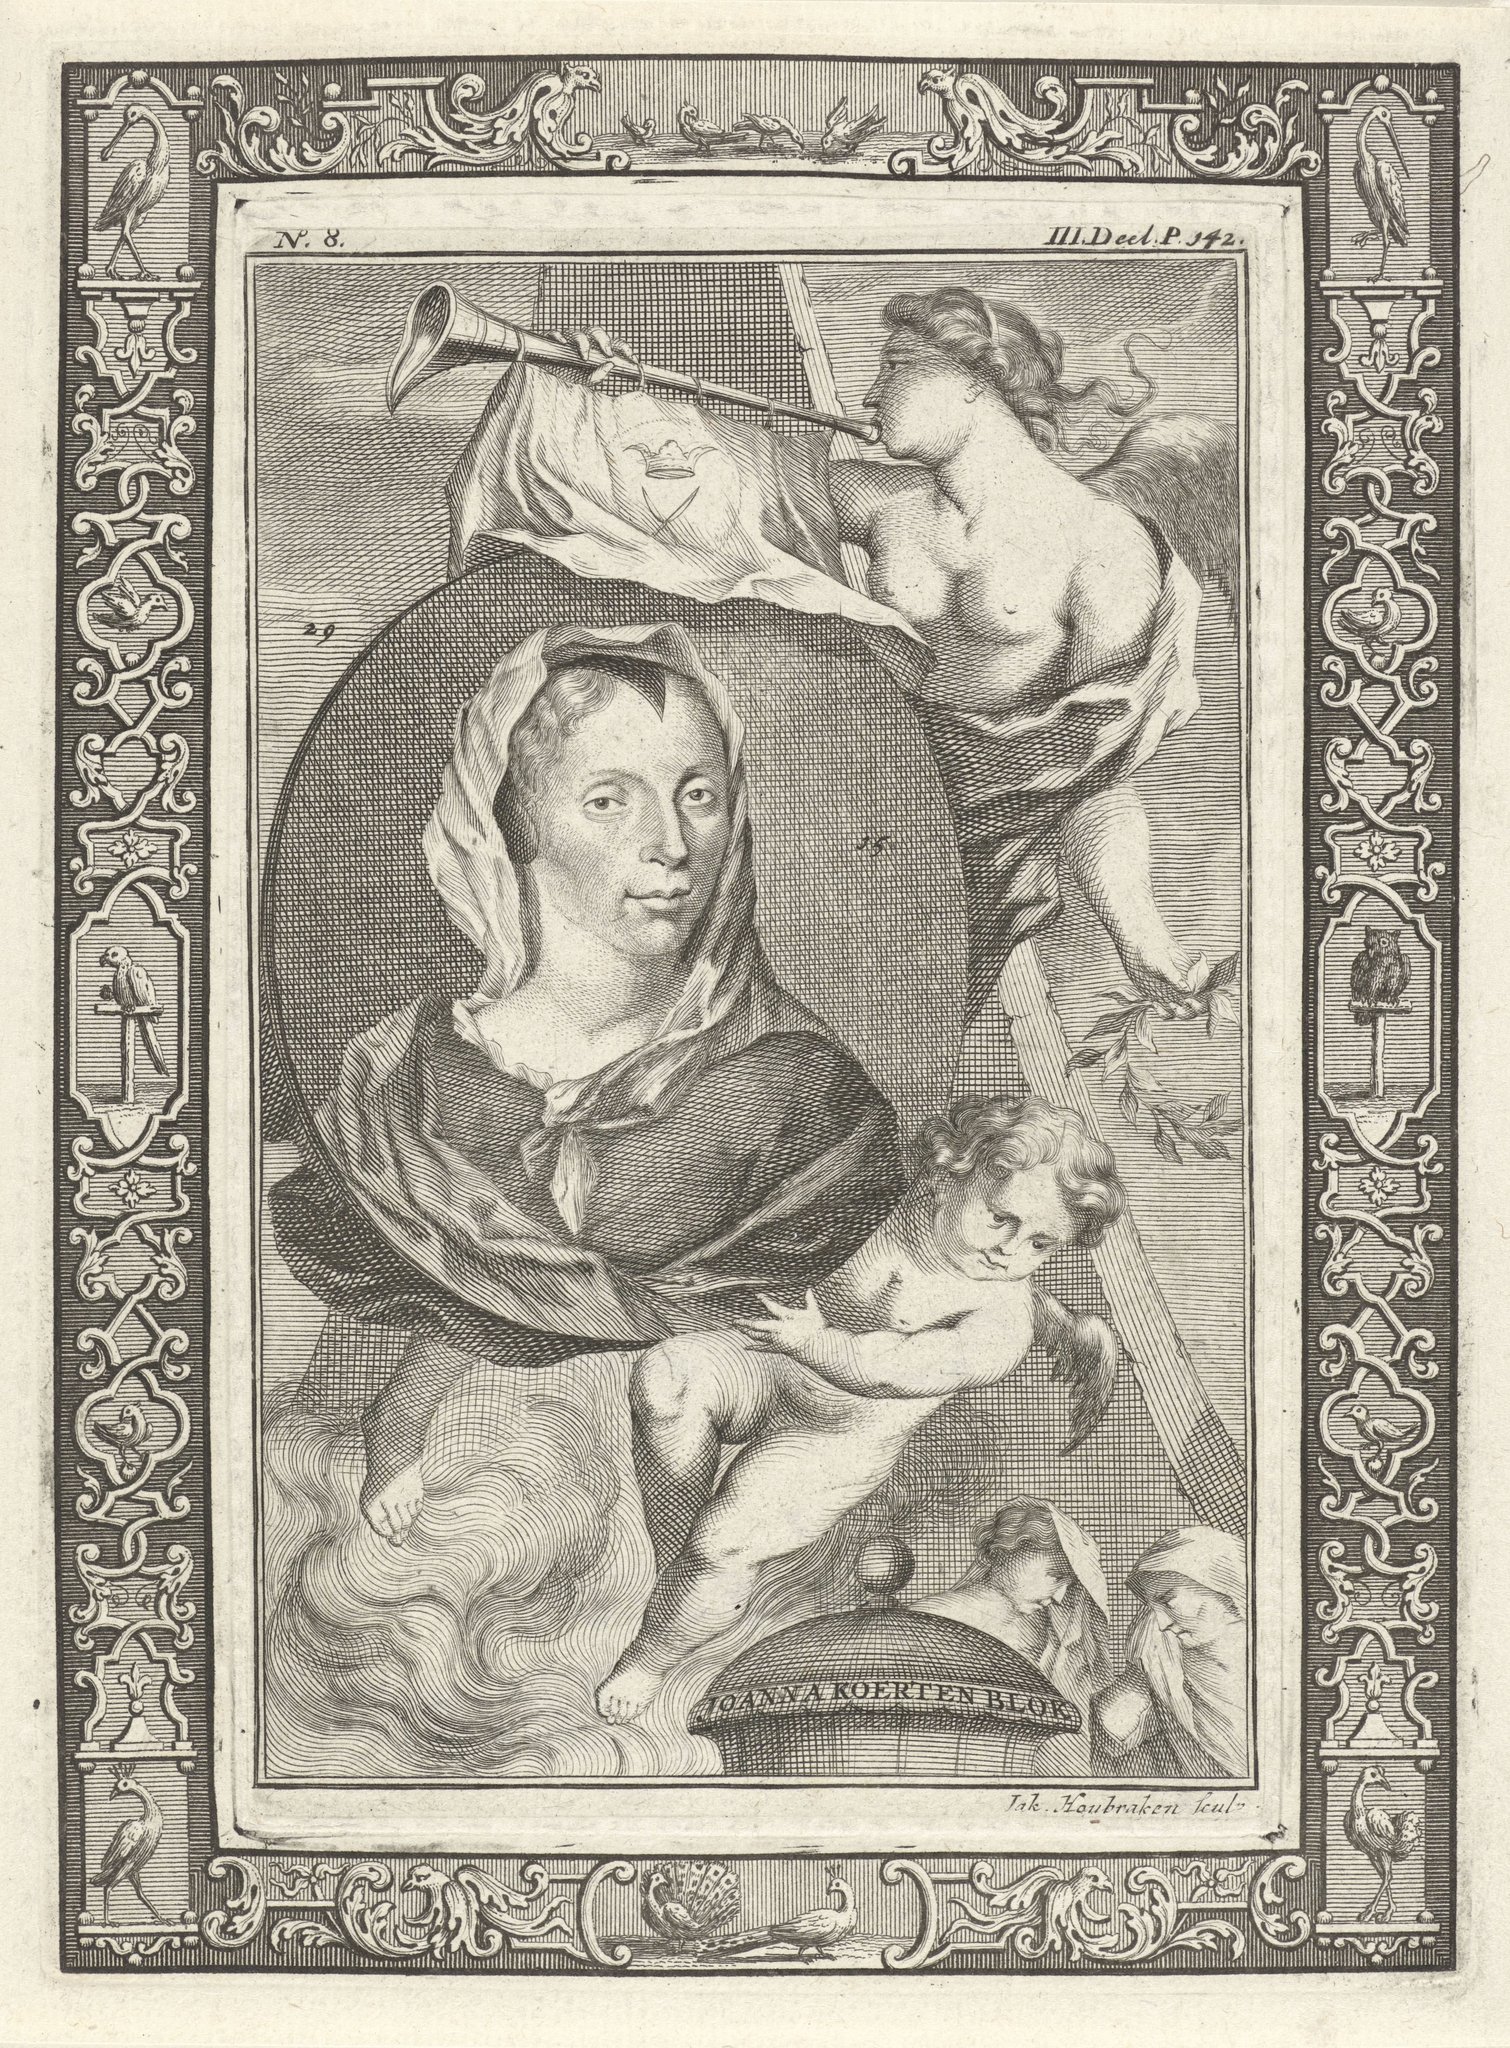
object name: book illustration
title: Portret van Johanna Koerten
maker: jacob houbraken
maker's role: draughtsman, print maker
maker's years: 1698-1780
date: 1729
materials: paper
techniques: engraving, etching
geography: amsterdam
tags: draughtsman, johanna koerten, fame; 'fama', 'fama buona', 'fama chiara' (ripa) (+ abstract concept represented by female figure)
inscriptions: collector's mark: Lugt 2228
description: Prent gebruikt in: Jacob Campo Weyerman. De levens-beschryvingen der Nederlandsche konst-schilders en konst-schilderessen, met een uytbreyding over de schilder-konst der ouden : verrykt met de konterfeytsels der voornaamste konst-schilders en konst-schilderessen, cierlyk in koper gesneden door J. Houbraken. 4 dln. Den Haag: Wed. E. Boucquet, H. Scheurleer, F. Bouquet en Jan de Jongh, 1729 (-1769).